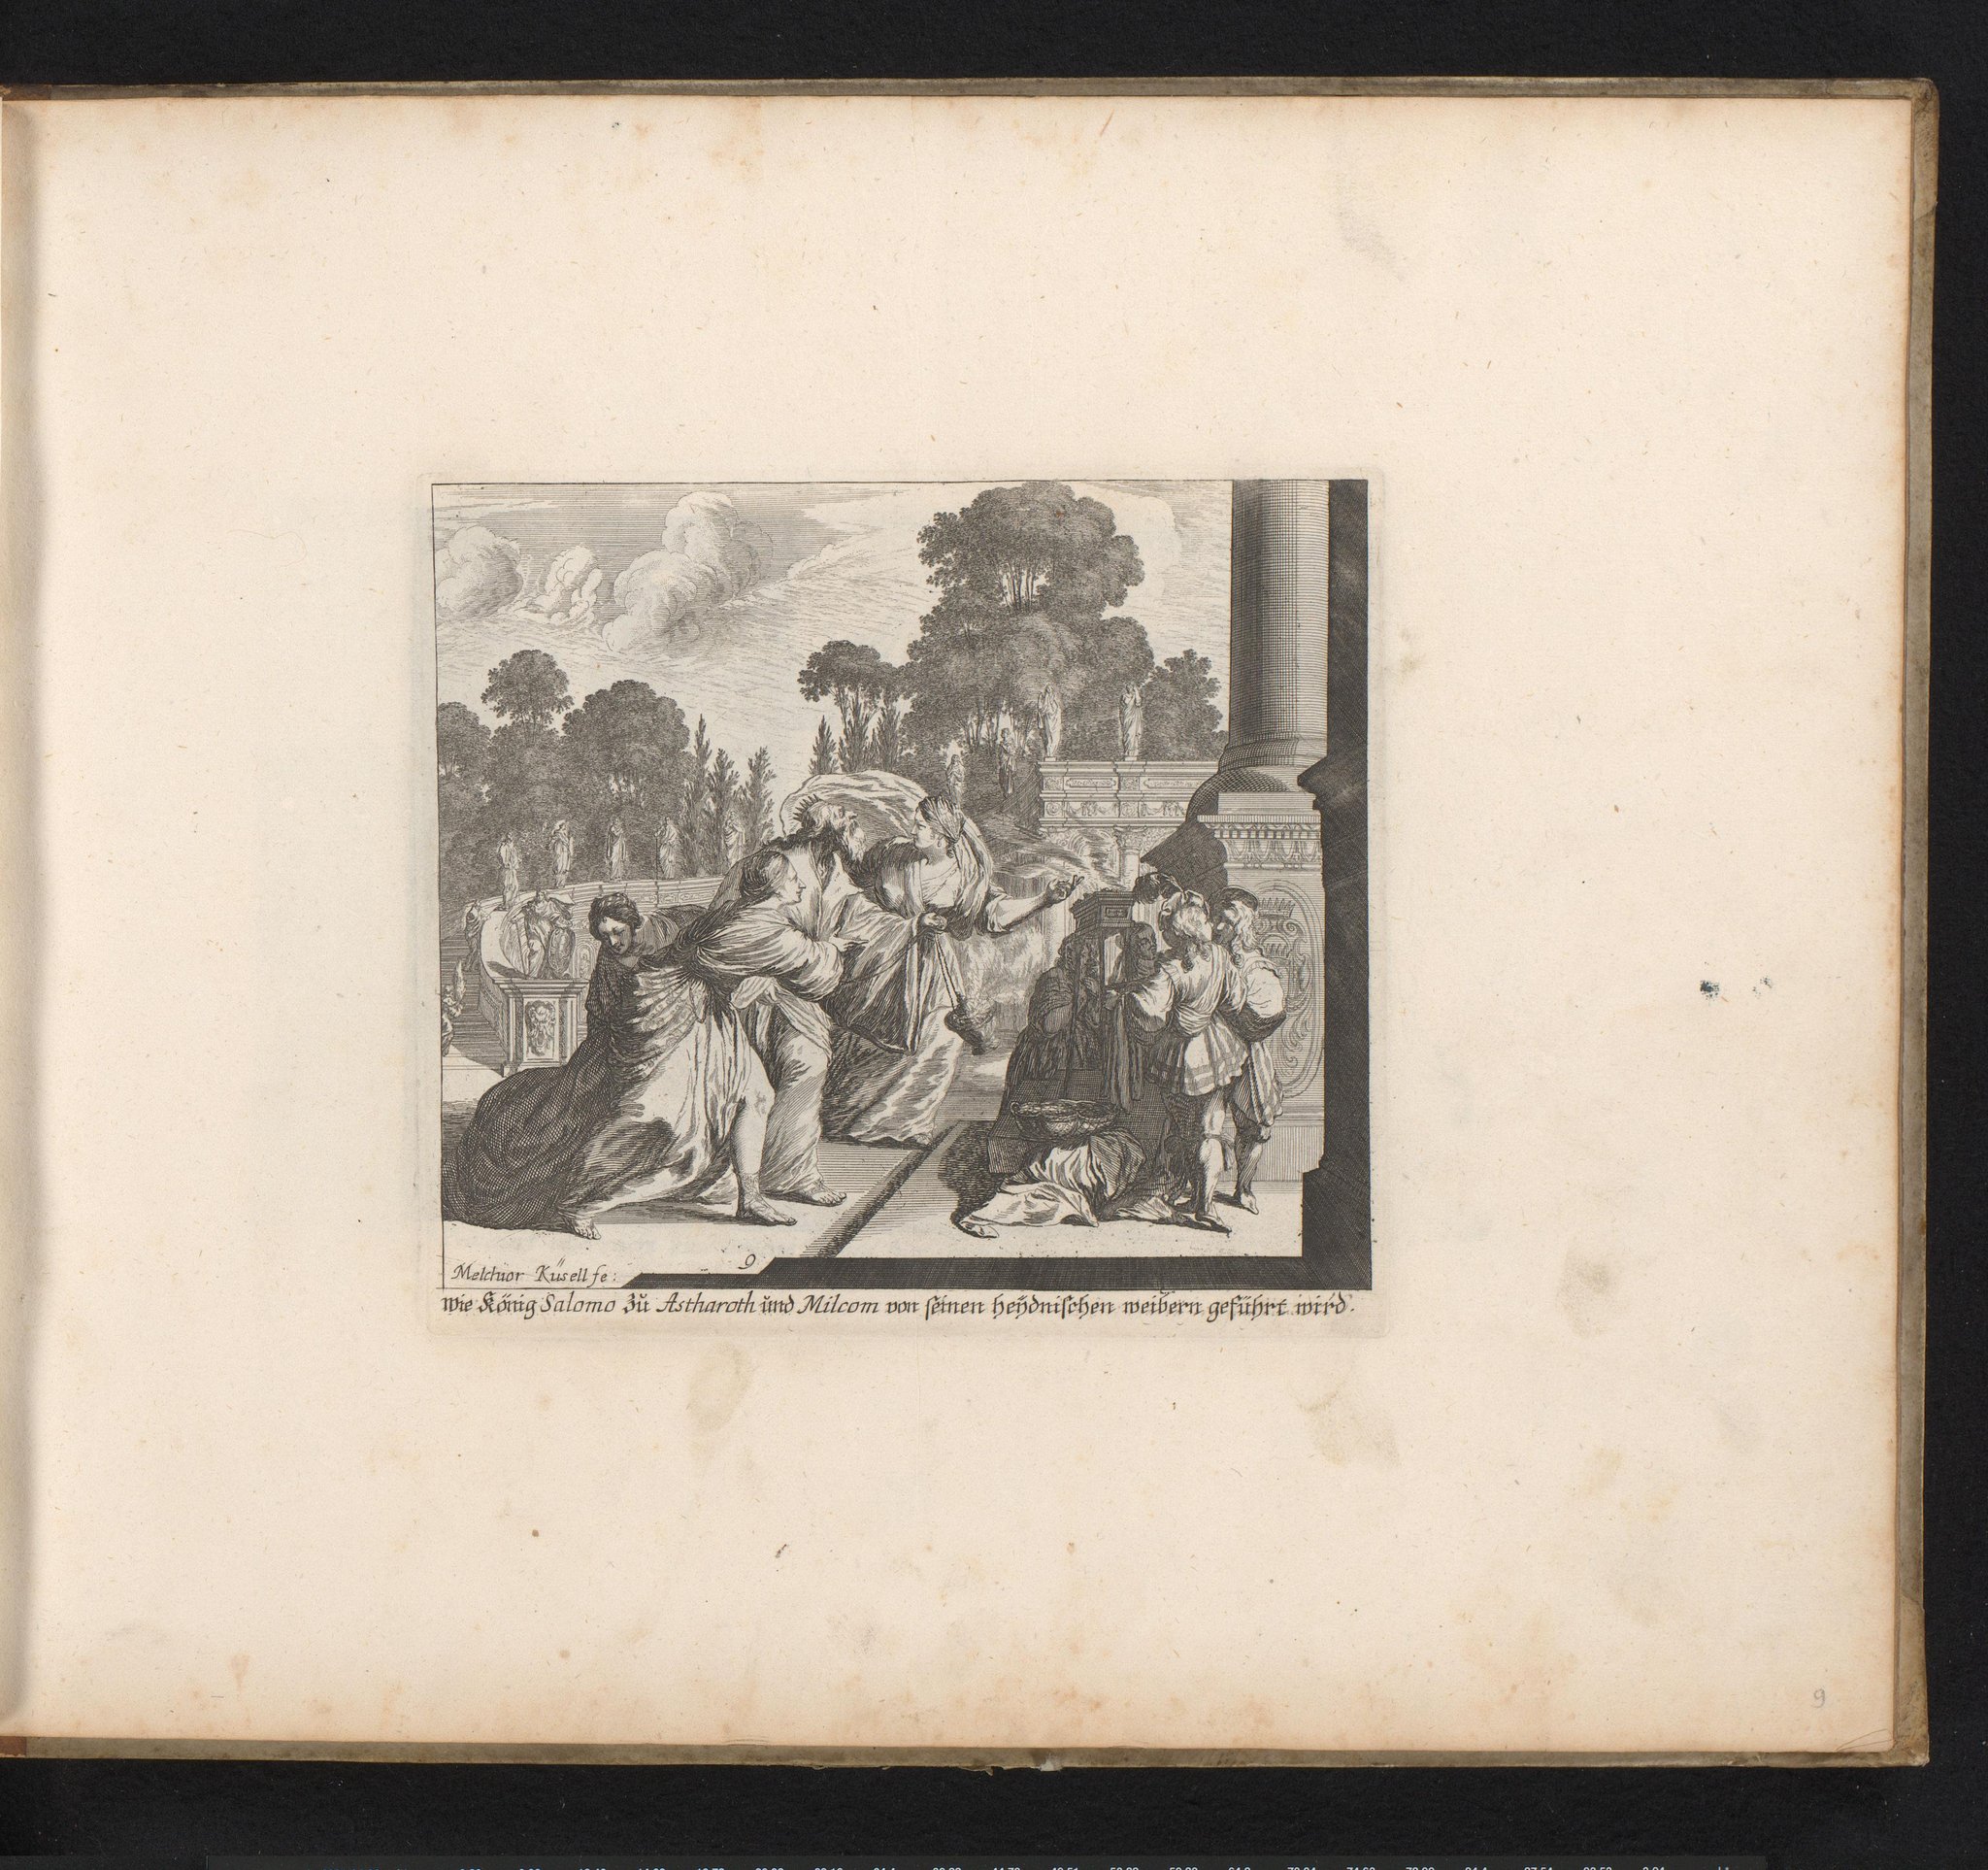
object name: print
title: Salomo's afgoderij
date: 1670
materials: paper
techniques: etching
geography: augsburg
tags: solomon's idolatry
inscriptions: collector's mark: Lugt 2228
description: Salomo met zijn vrouwen bij de tempels voor Moloch en Astarte. Tekst in het Duits in de ondermarge. Rechtsonder genummerd: 9. Prent maakt deel uit van een album.